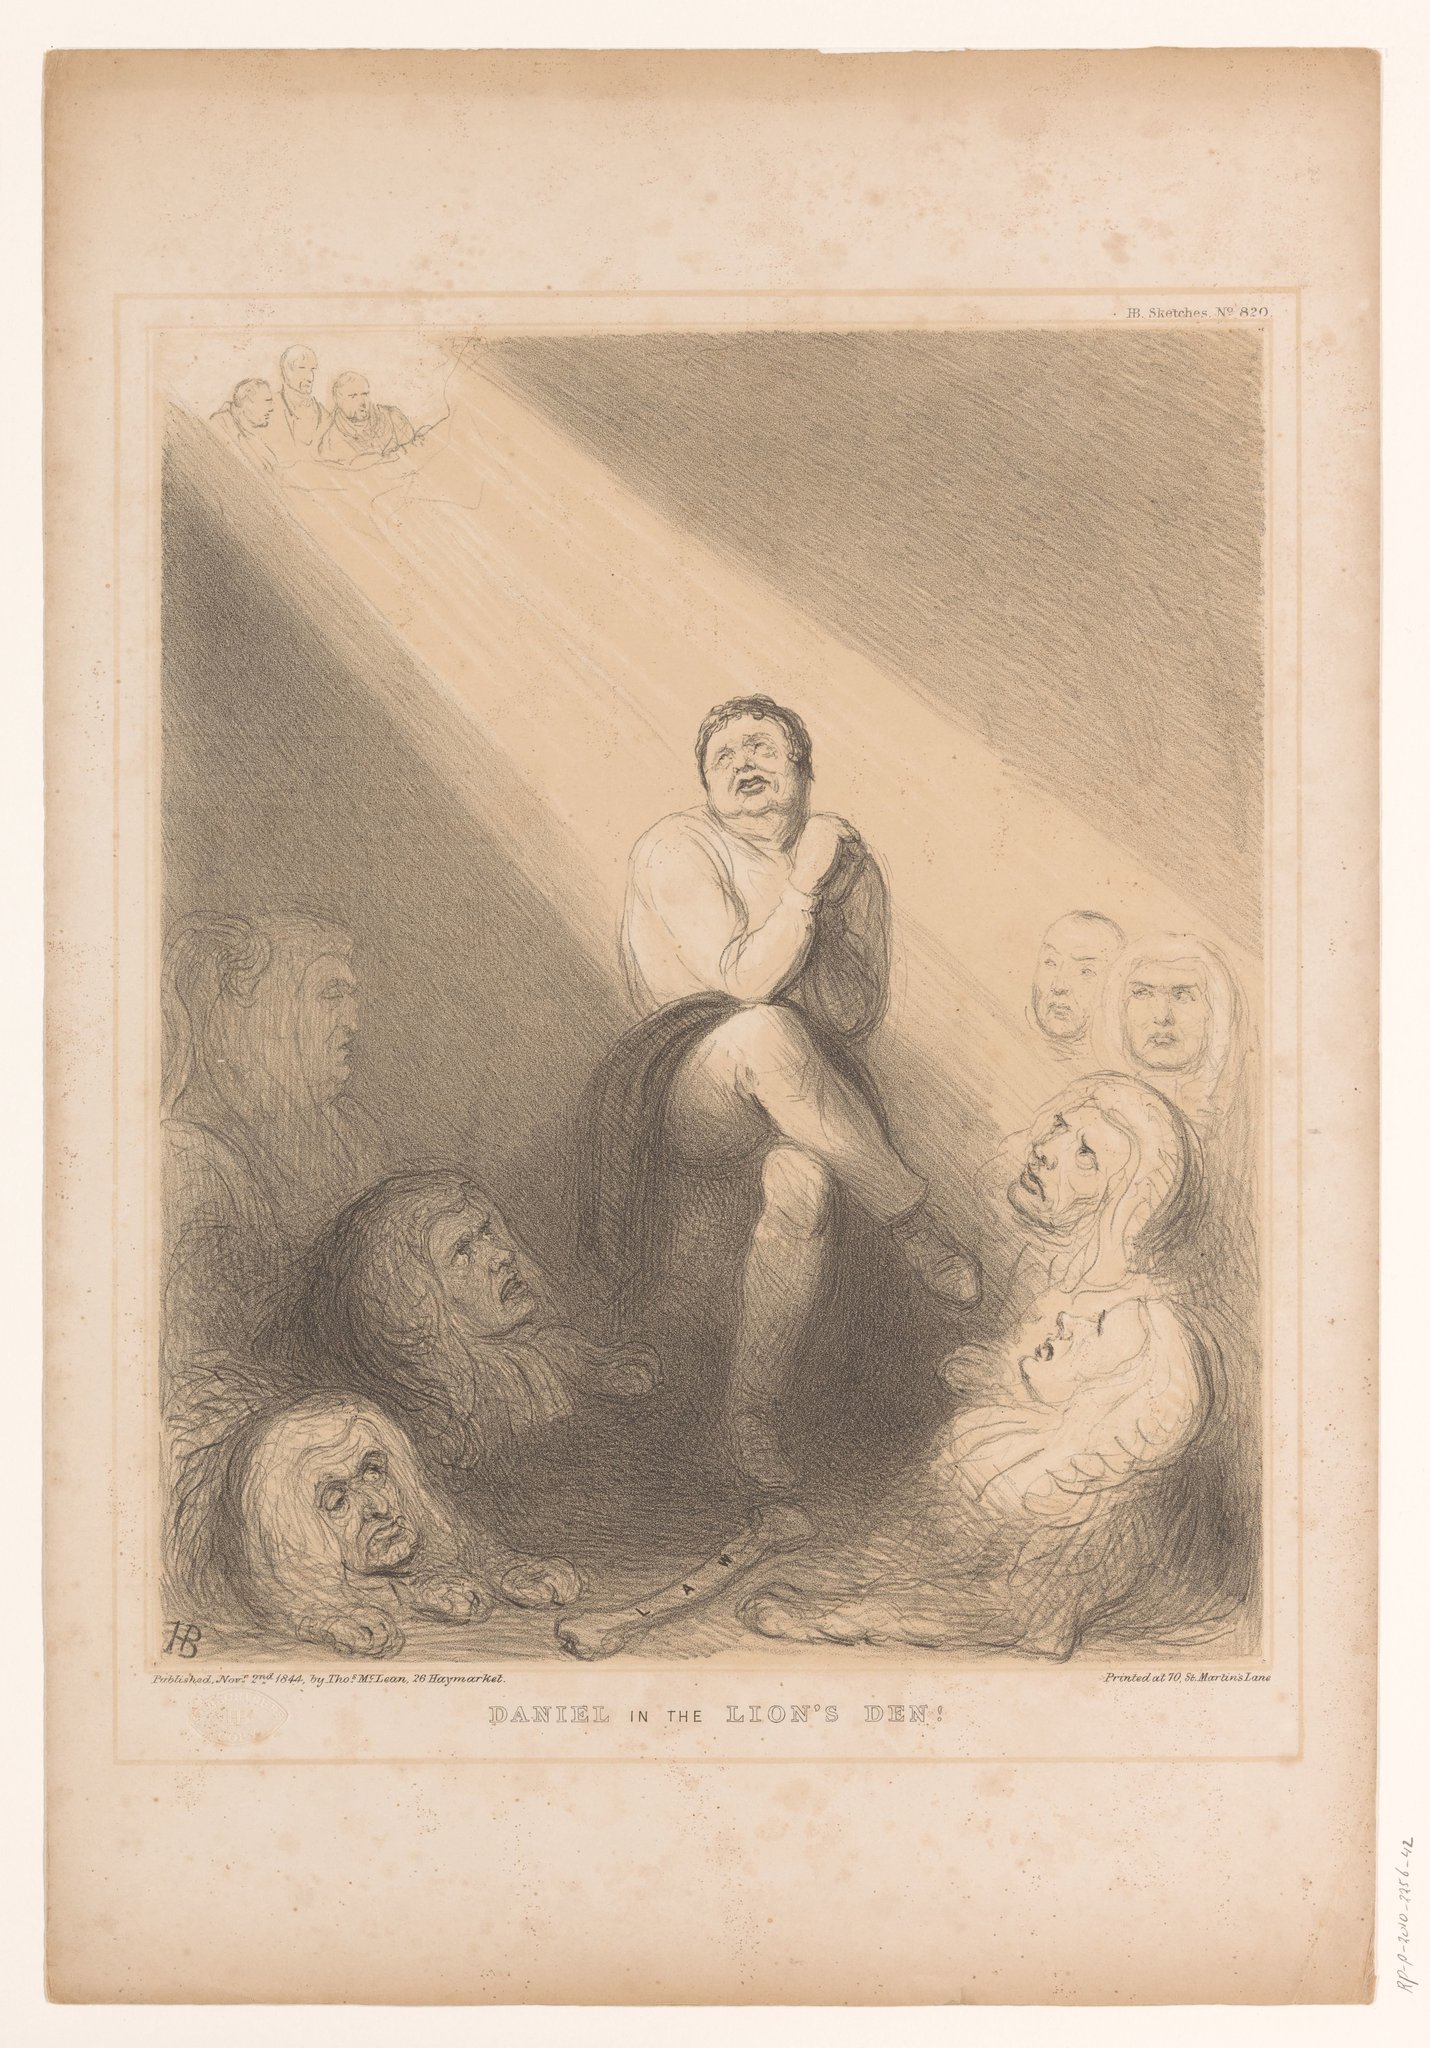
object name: cartoon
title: HB Sketches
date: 1844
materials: paper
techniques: tone lithography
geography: london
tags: king cyrus visits the lion's den and finds daniel alive, political caricatures and satires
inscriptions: stamp: ‘HB Subscribers Copy’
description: Spotprent uit 1844 met Daniel O'Connell in de leeuwenkuil. Uitgegeven als nr. 820 in de serie HB Sketches.